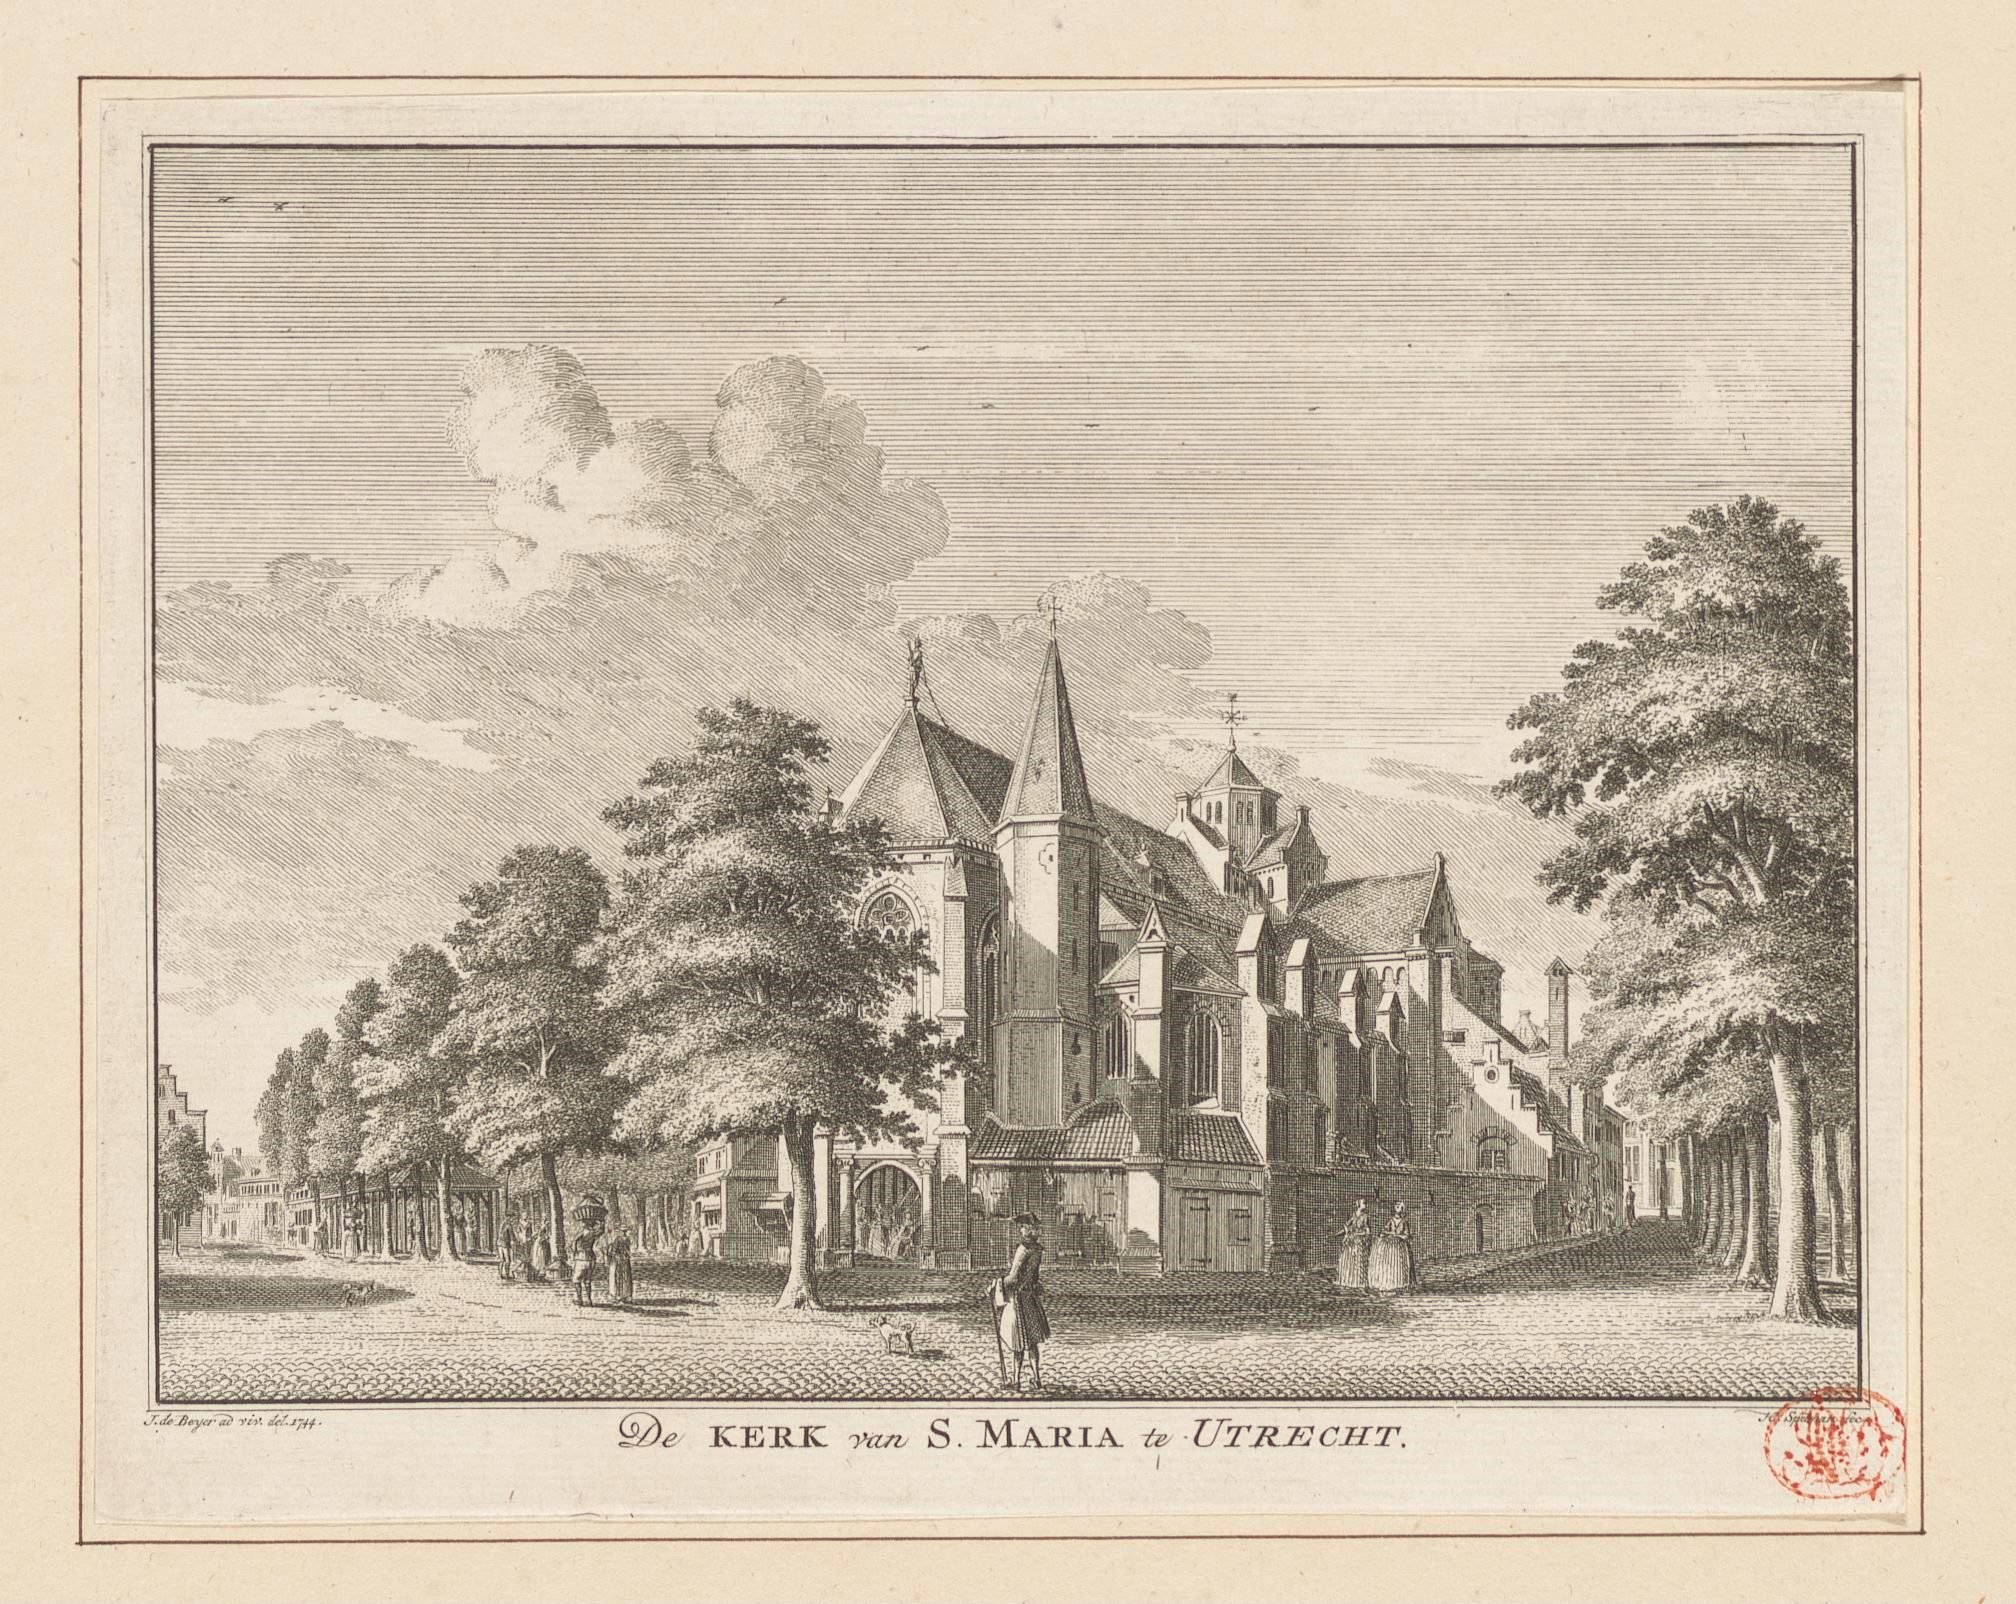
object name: print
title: Gezicht op de Catharijnekerk te Utrecht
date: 1744-1758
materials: paper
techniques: engraving, etching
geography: amsterdam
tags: church (exterior)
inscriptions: collector's mark: Lugt 195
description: Prent ook gebruikt in: Tegenwoordige staat der Vereenigde Nederlanden, elfde deel, behelzende eene beschryving van de provincie van Utrecht. Met landkaarten, plans der steden en printverbeeldingen versierd / Hedendaagsche historie, of tegenwoordige staat van alle volkeren; XXI. deel (…). Amsterdam: Isaak Tirion, 1758, tussen p. 376 en p. 377.